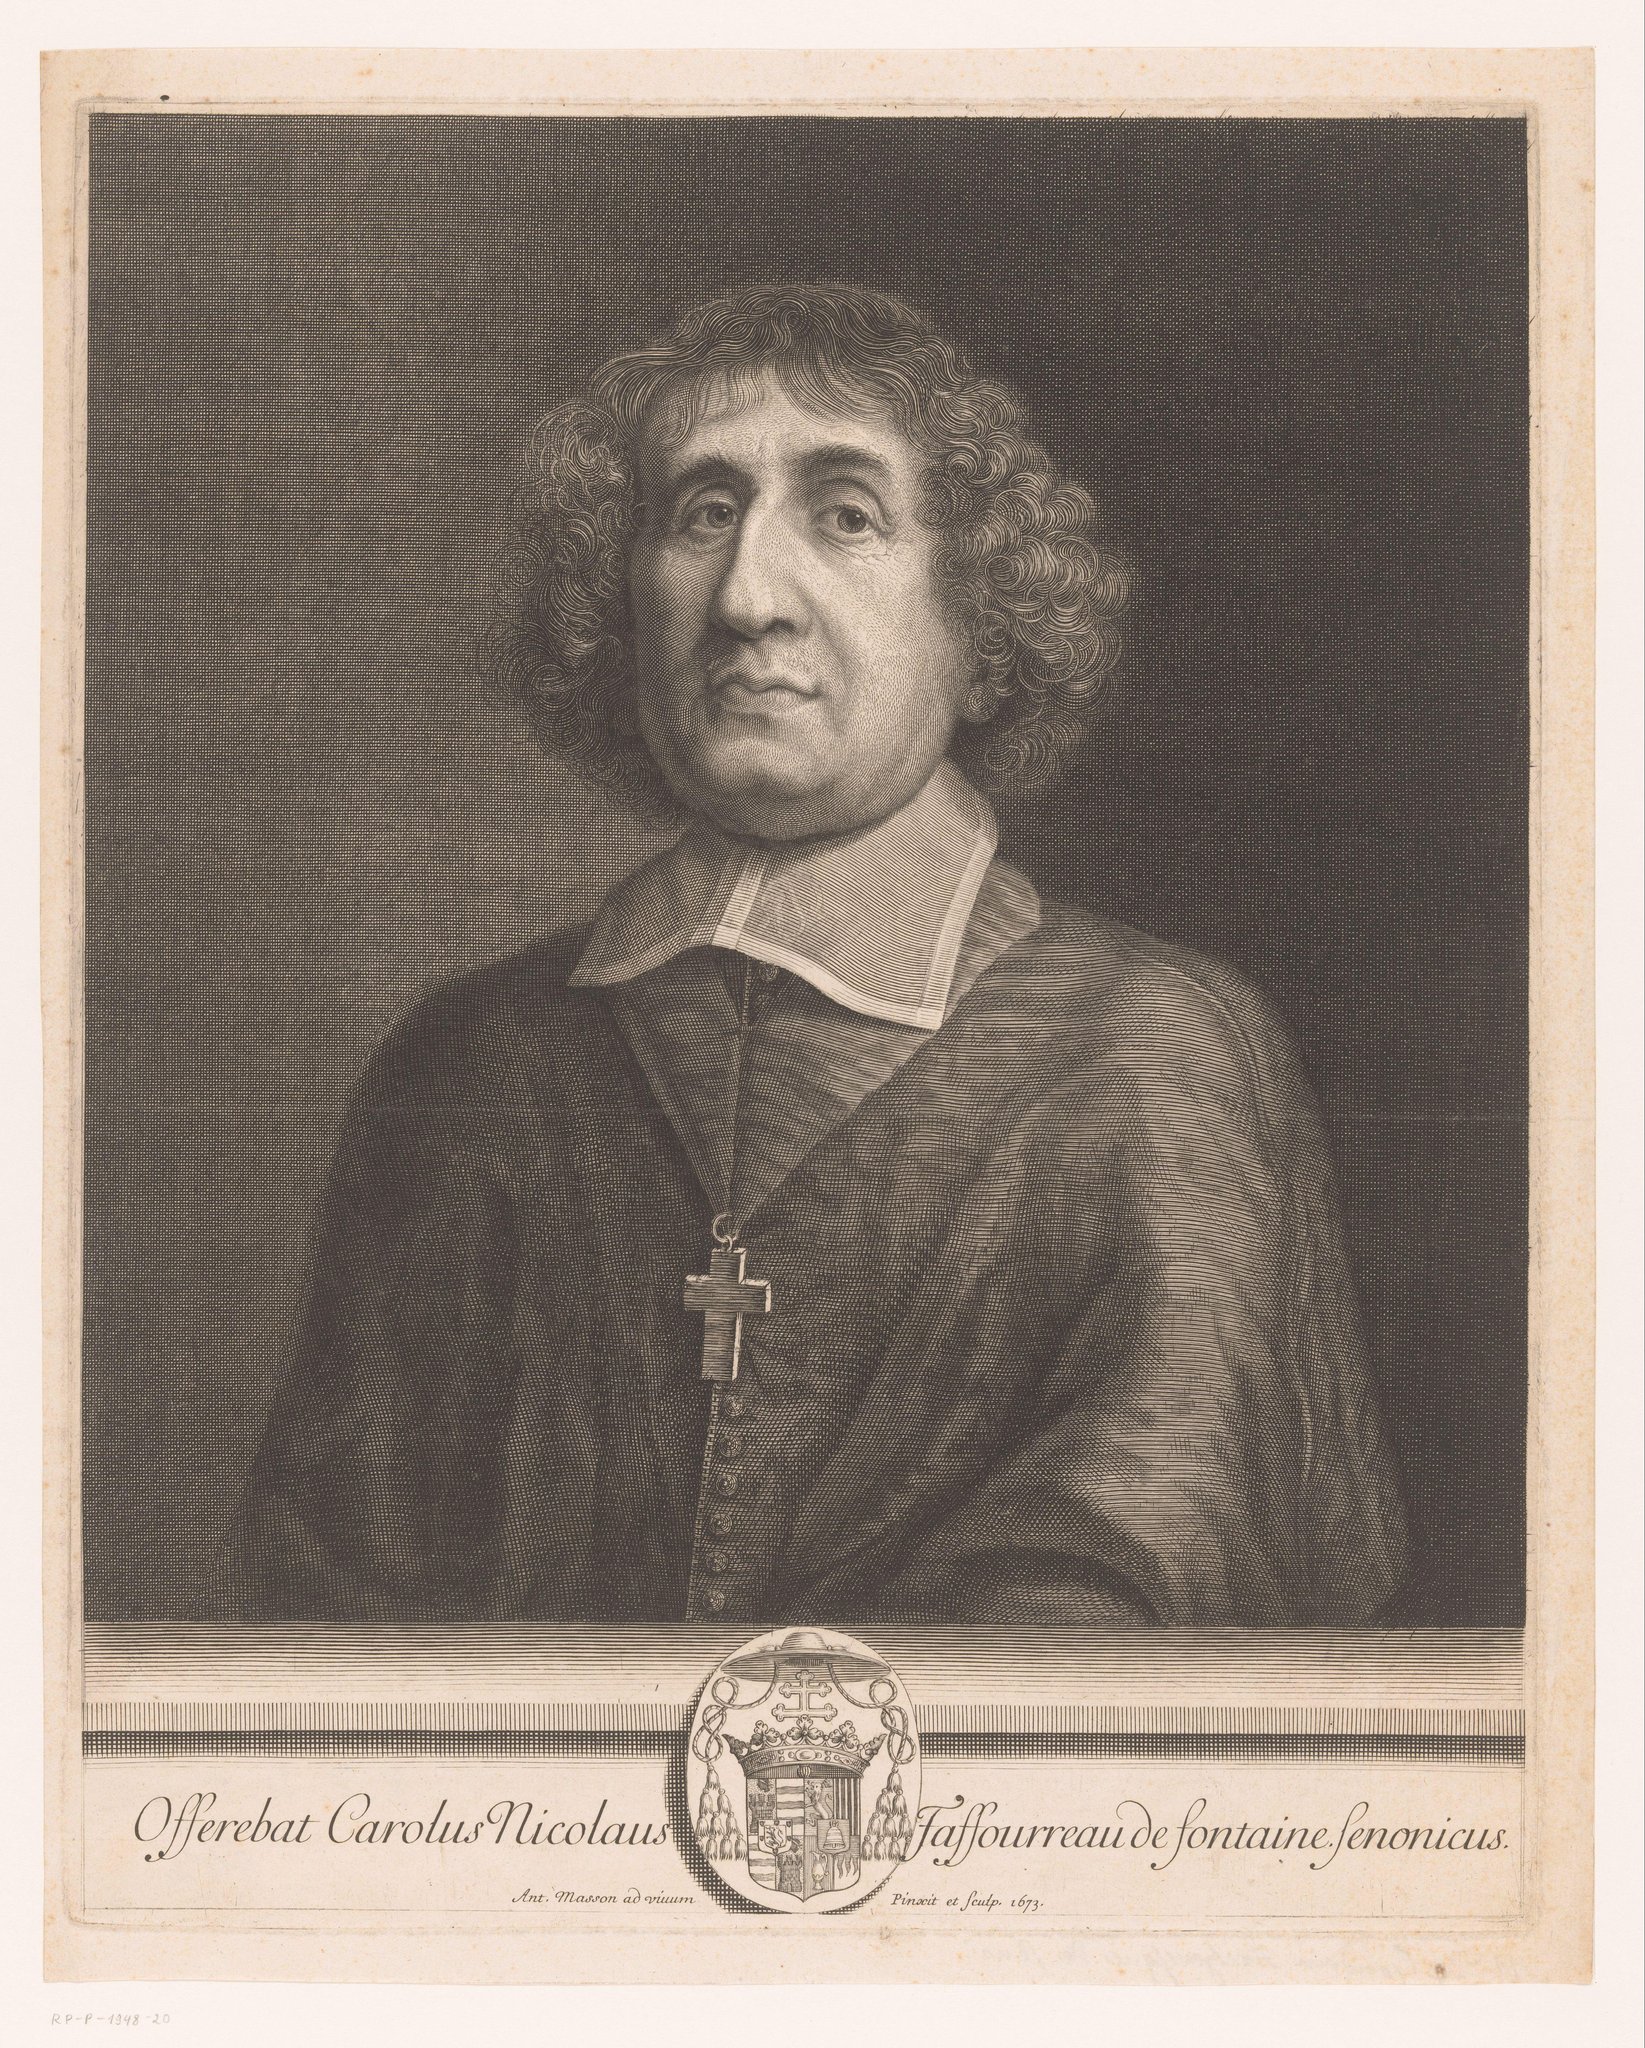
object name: print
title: Portret van Louis Henri de Pardaillan de Gondrin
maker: antoine masson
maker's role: print maker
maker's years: 1636-1700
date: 1673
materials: paper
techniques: engraving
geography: france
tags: historical persons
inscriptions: collector's mark: Lugt 2228